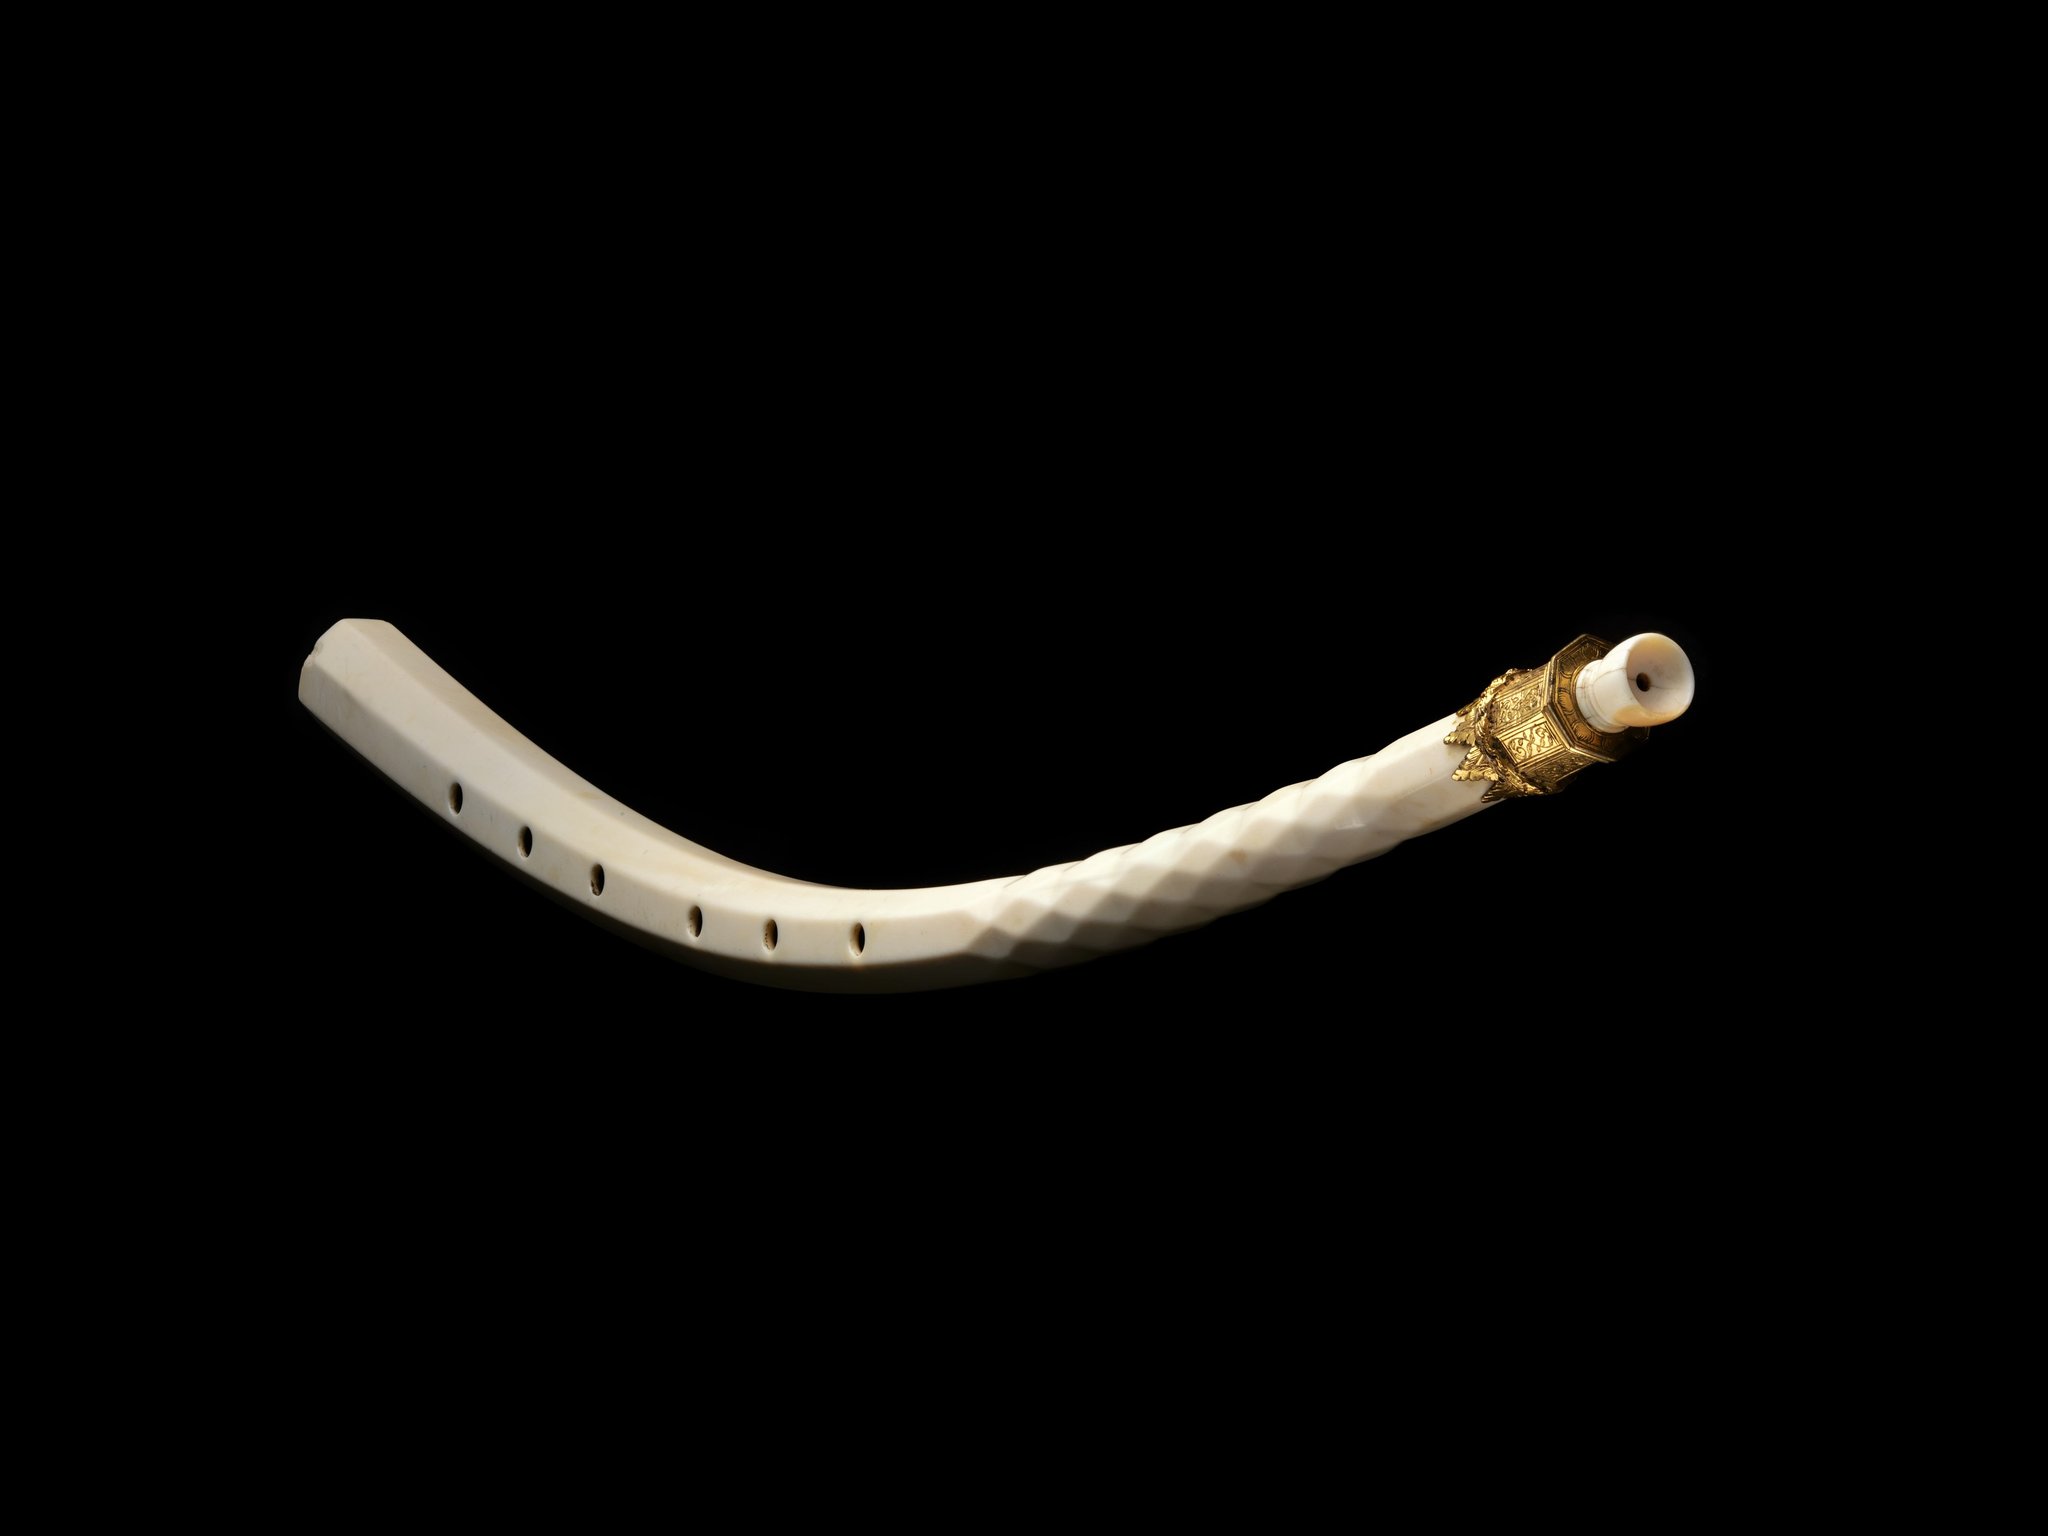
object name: cornetto in a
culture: german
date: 1575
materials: gilt, ivory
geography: germany